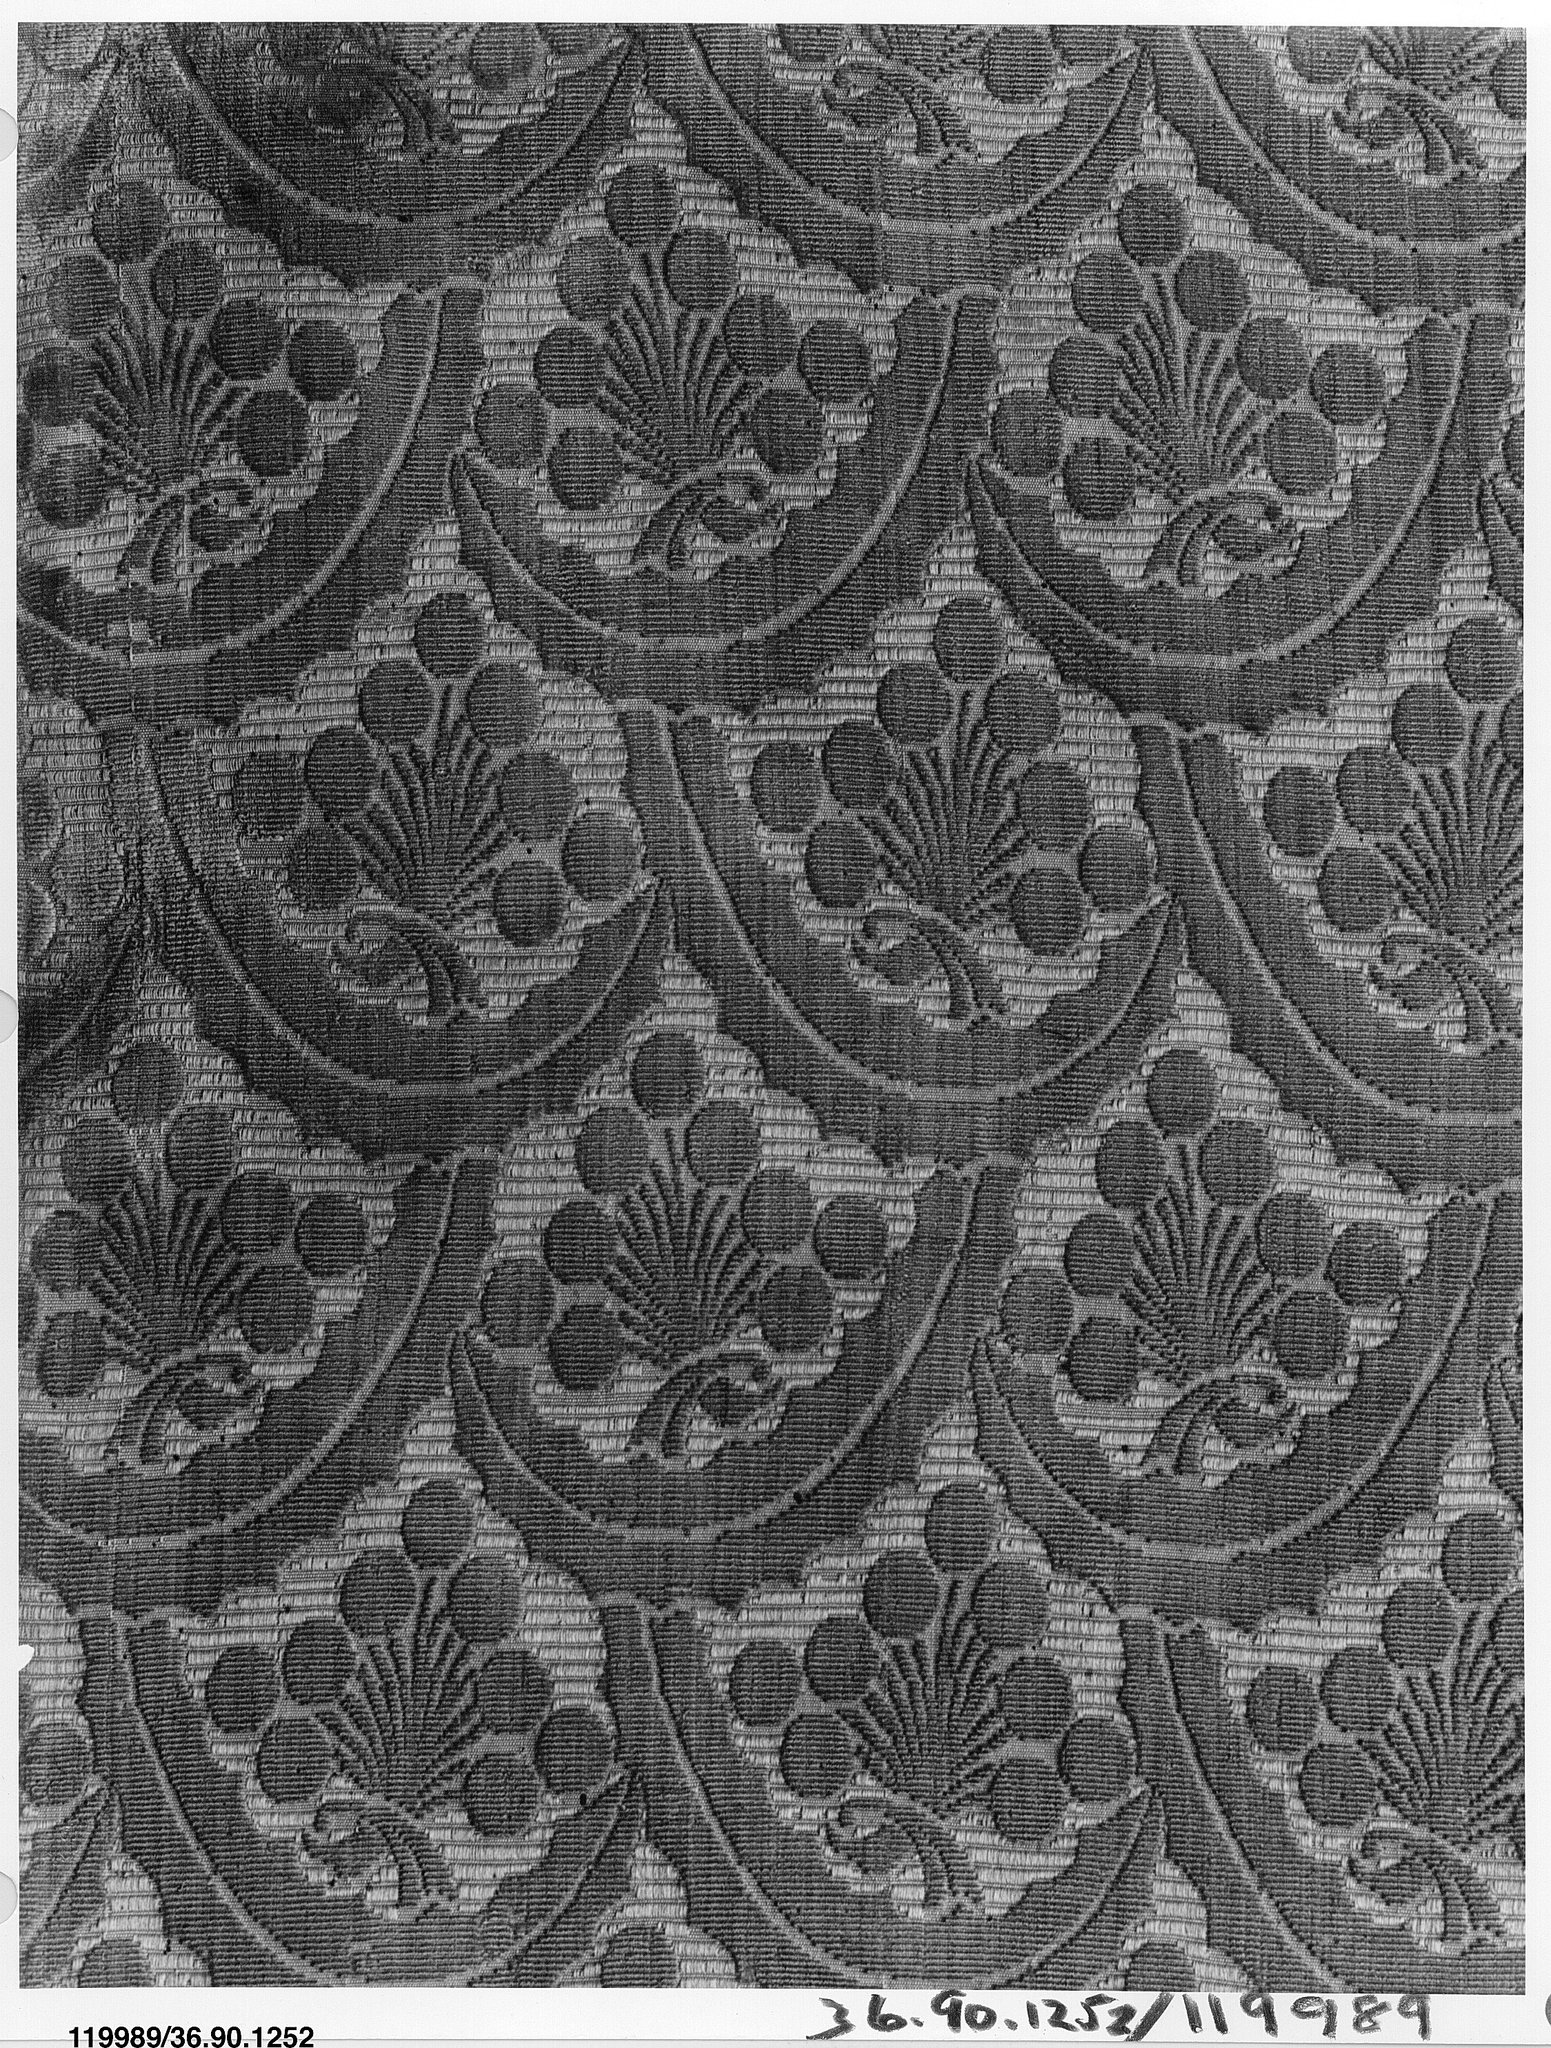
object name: piece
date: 1701-1800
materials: silk